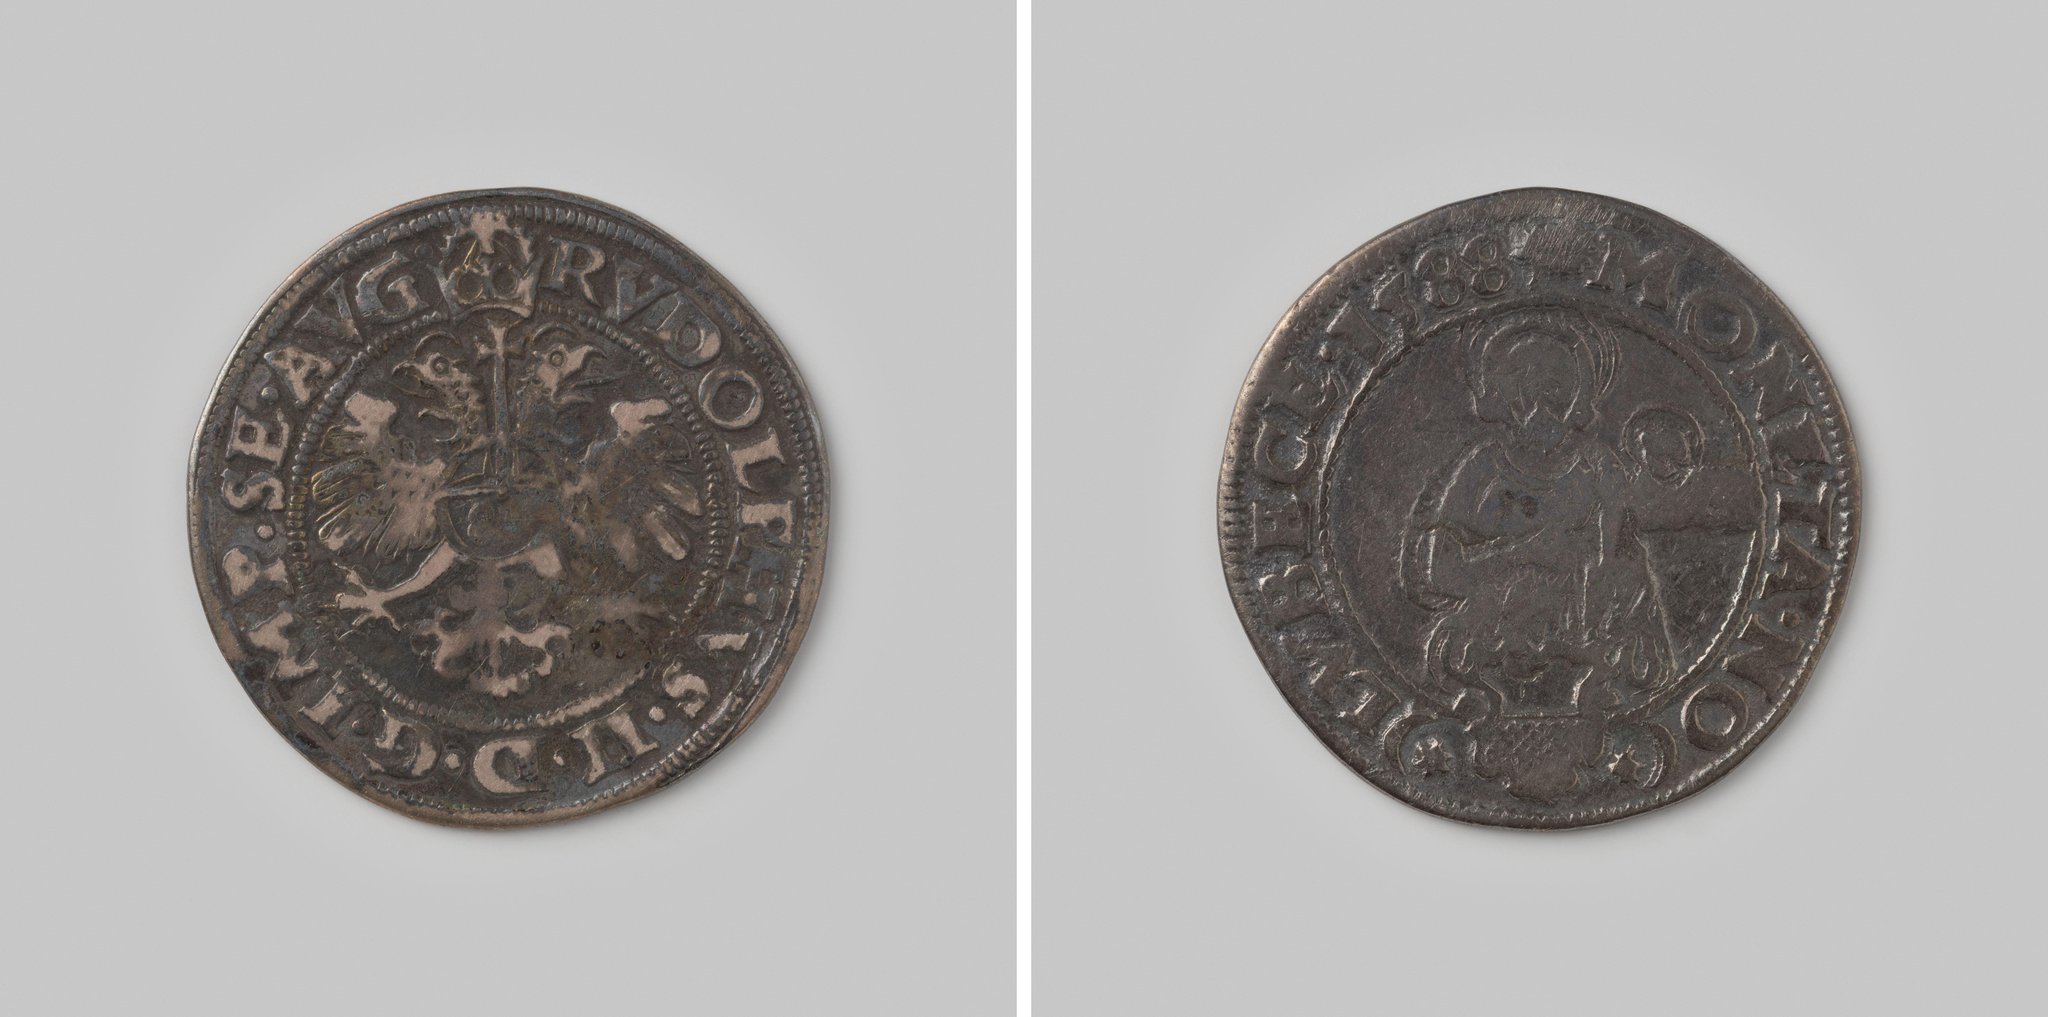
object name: coin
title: Vrije Hanzestad Lübeck, kwart taler, 1588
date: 1588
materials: silver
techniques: striking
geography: lübeck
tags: prague, rudolf ii van habsburg (duits keizer)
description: Zilveren munt. Voorzijde: gekroonde dubbelkoppige adelaar met op de borst de rijksappel. Keerzijde: heilige met het lam, waaronder wapenschild van de stad.